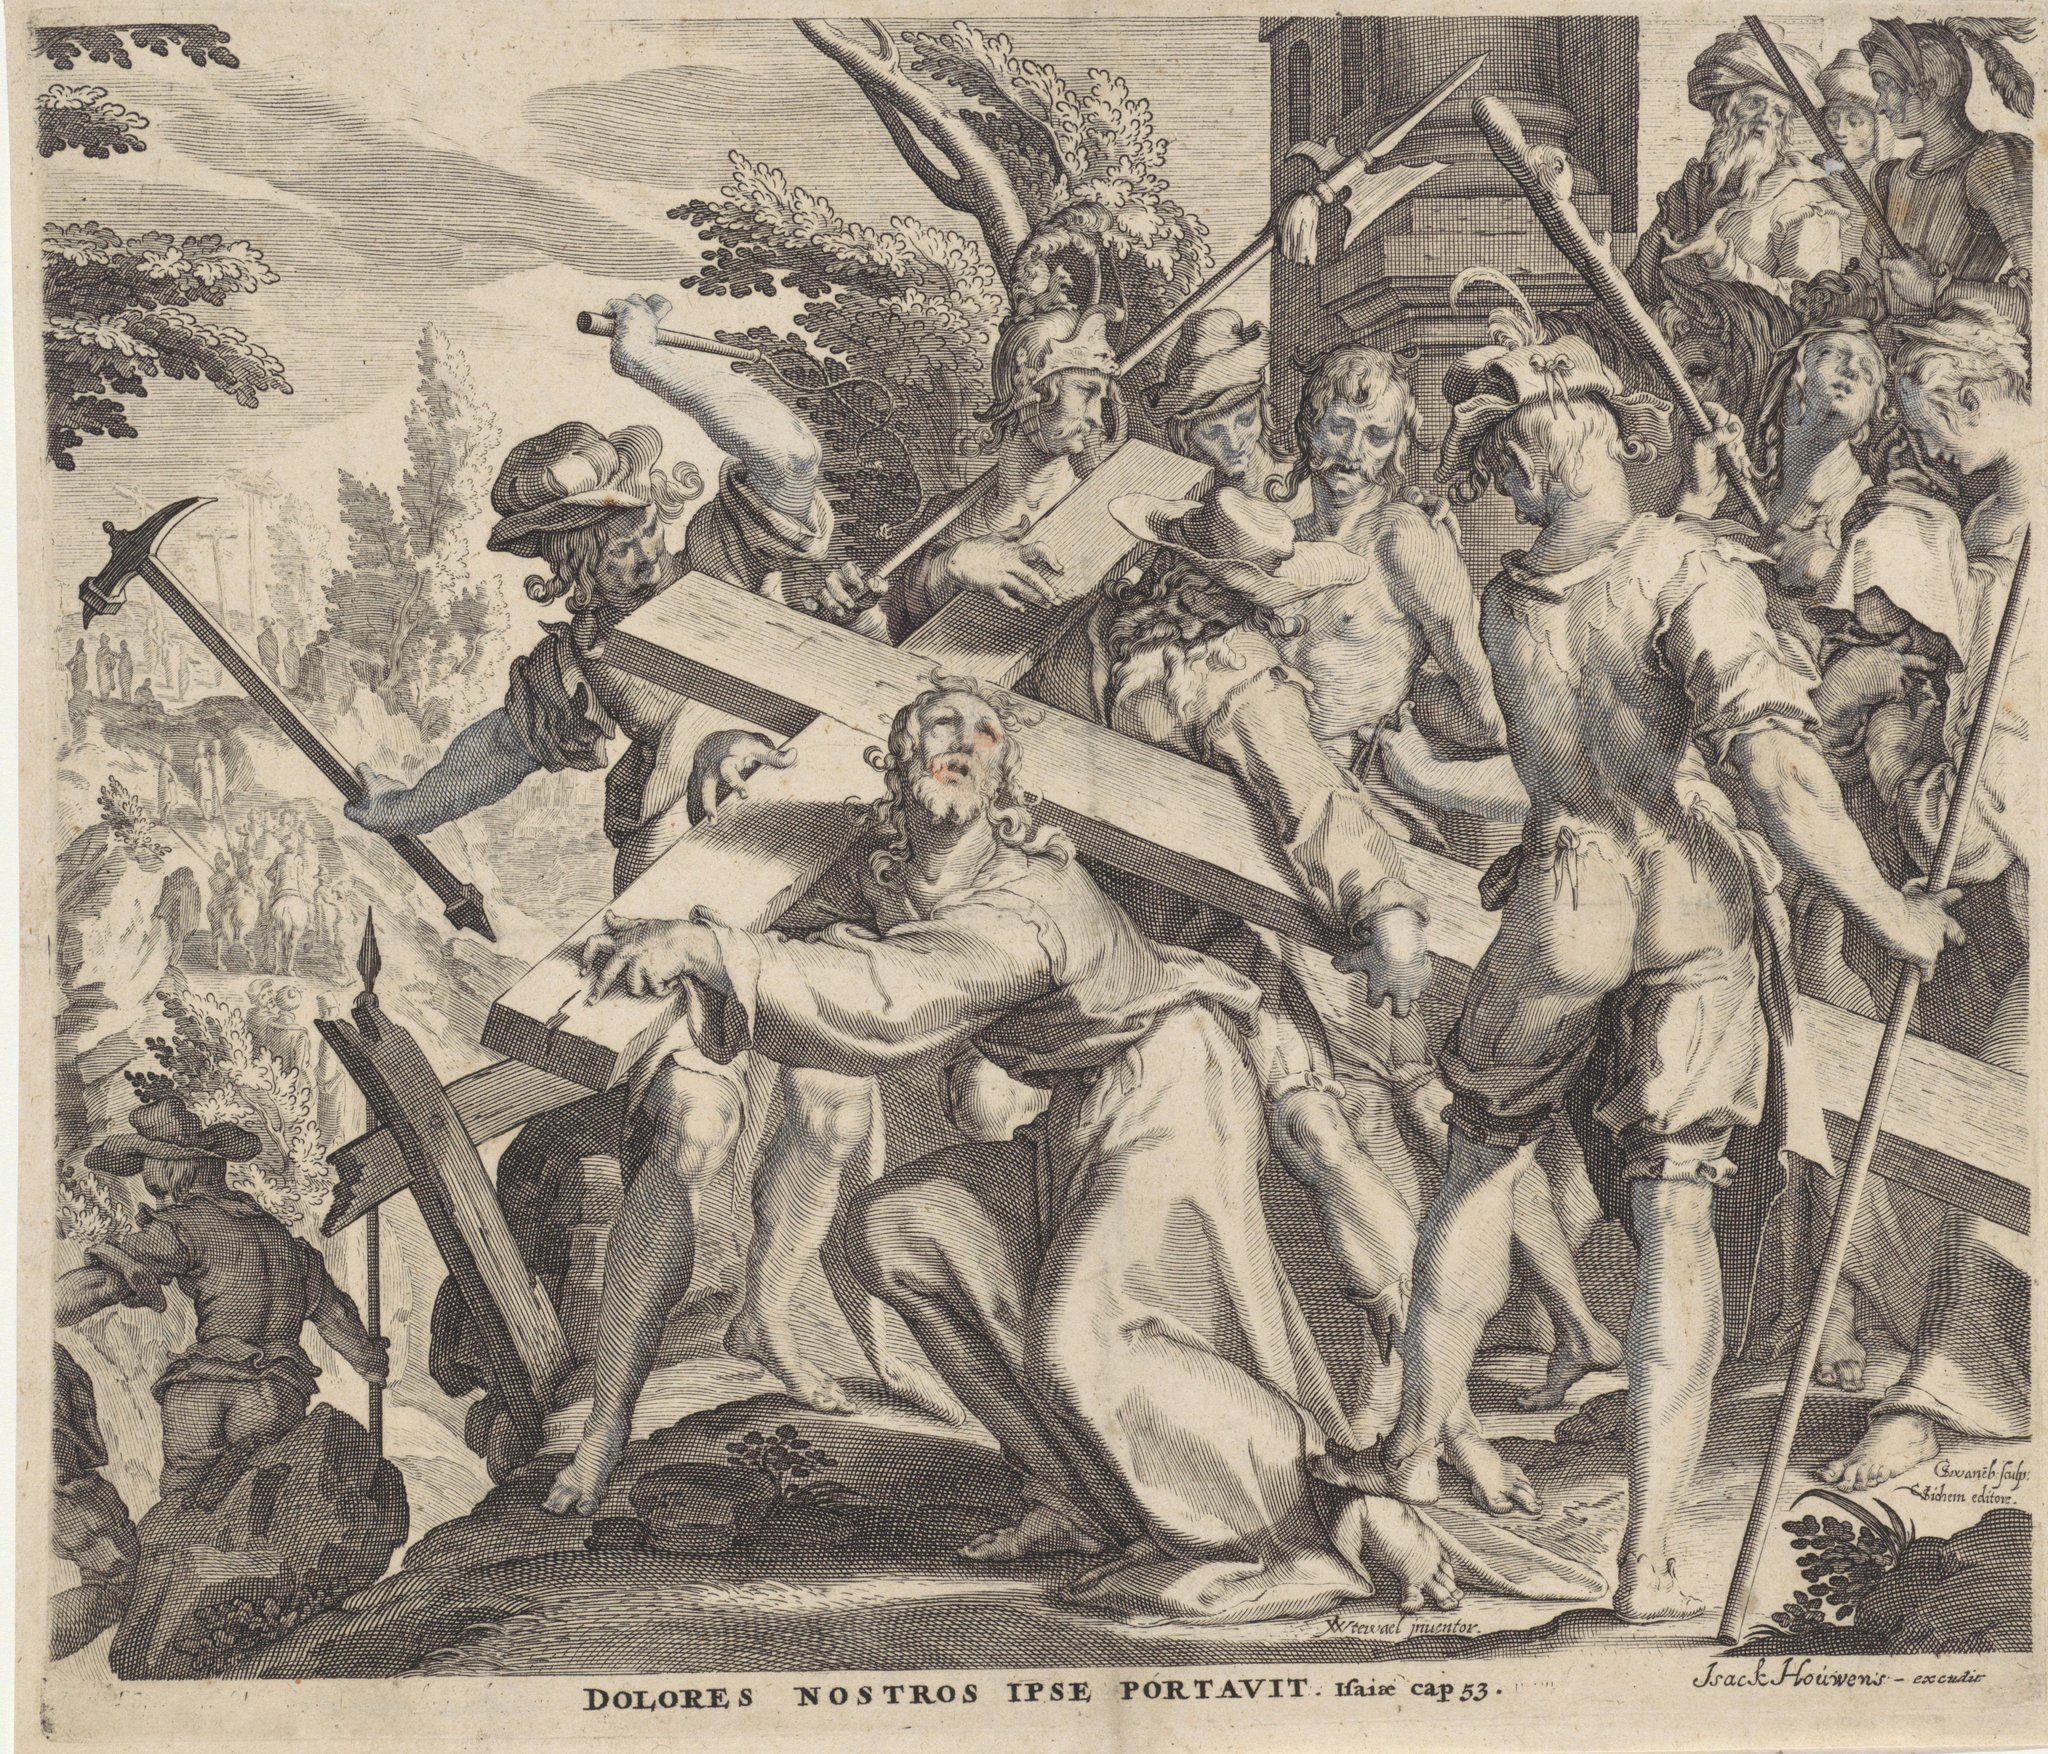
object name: print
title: Thronus Justitiae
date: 1606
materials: paper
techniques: engraving, hand coloring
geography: leiden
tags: christ collapsing ~ carrying of the cross, juridical examples; exemplary judges; 'gerechtigkeitsbilder', carrying of the cross: christ bearing the cross, alone or with the help of others (e.g. simon the cyrenian)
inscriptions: collector's mark: Lugt 2228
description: Christus draagt het kruis en Simon van Cyrene helpt hem daarbij. Soldaten geselen en bespotten Christus. Hij wordt gevolgd door Maria. Links een van de andere misdadigers, die geboeid naar Golgota wordt geleid. Op de achtergrond in het landschap de drie kruisen. Onder de voorstelling een verwijzing naar de Bijbeltekst in Jes. 53 in het Latijn.